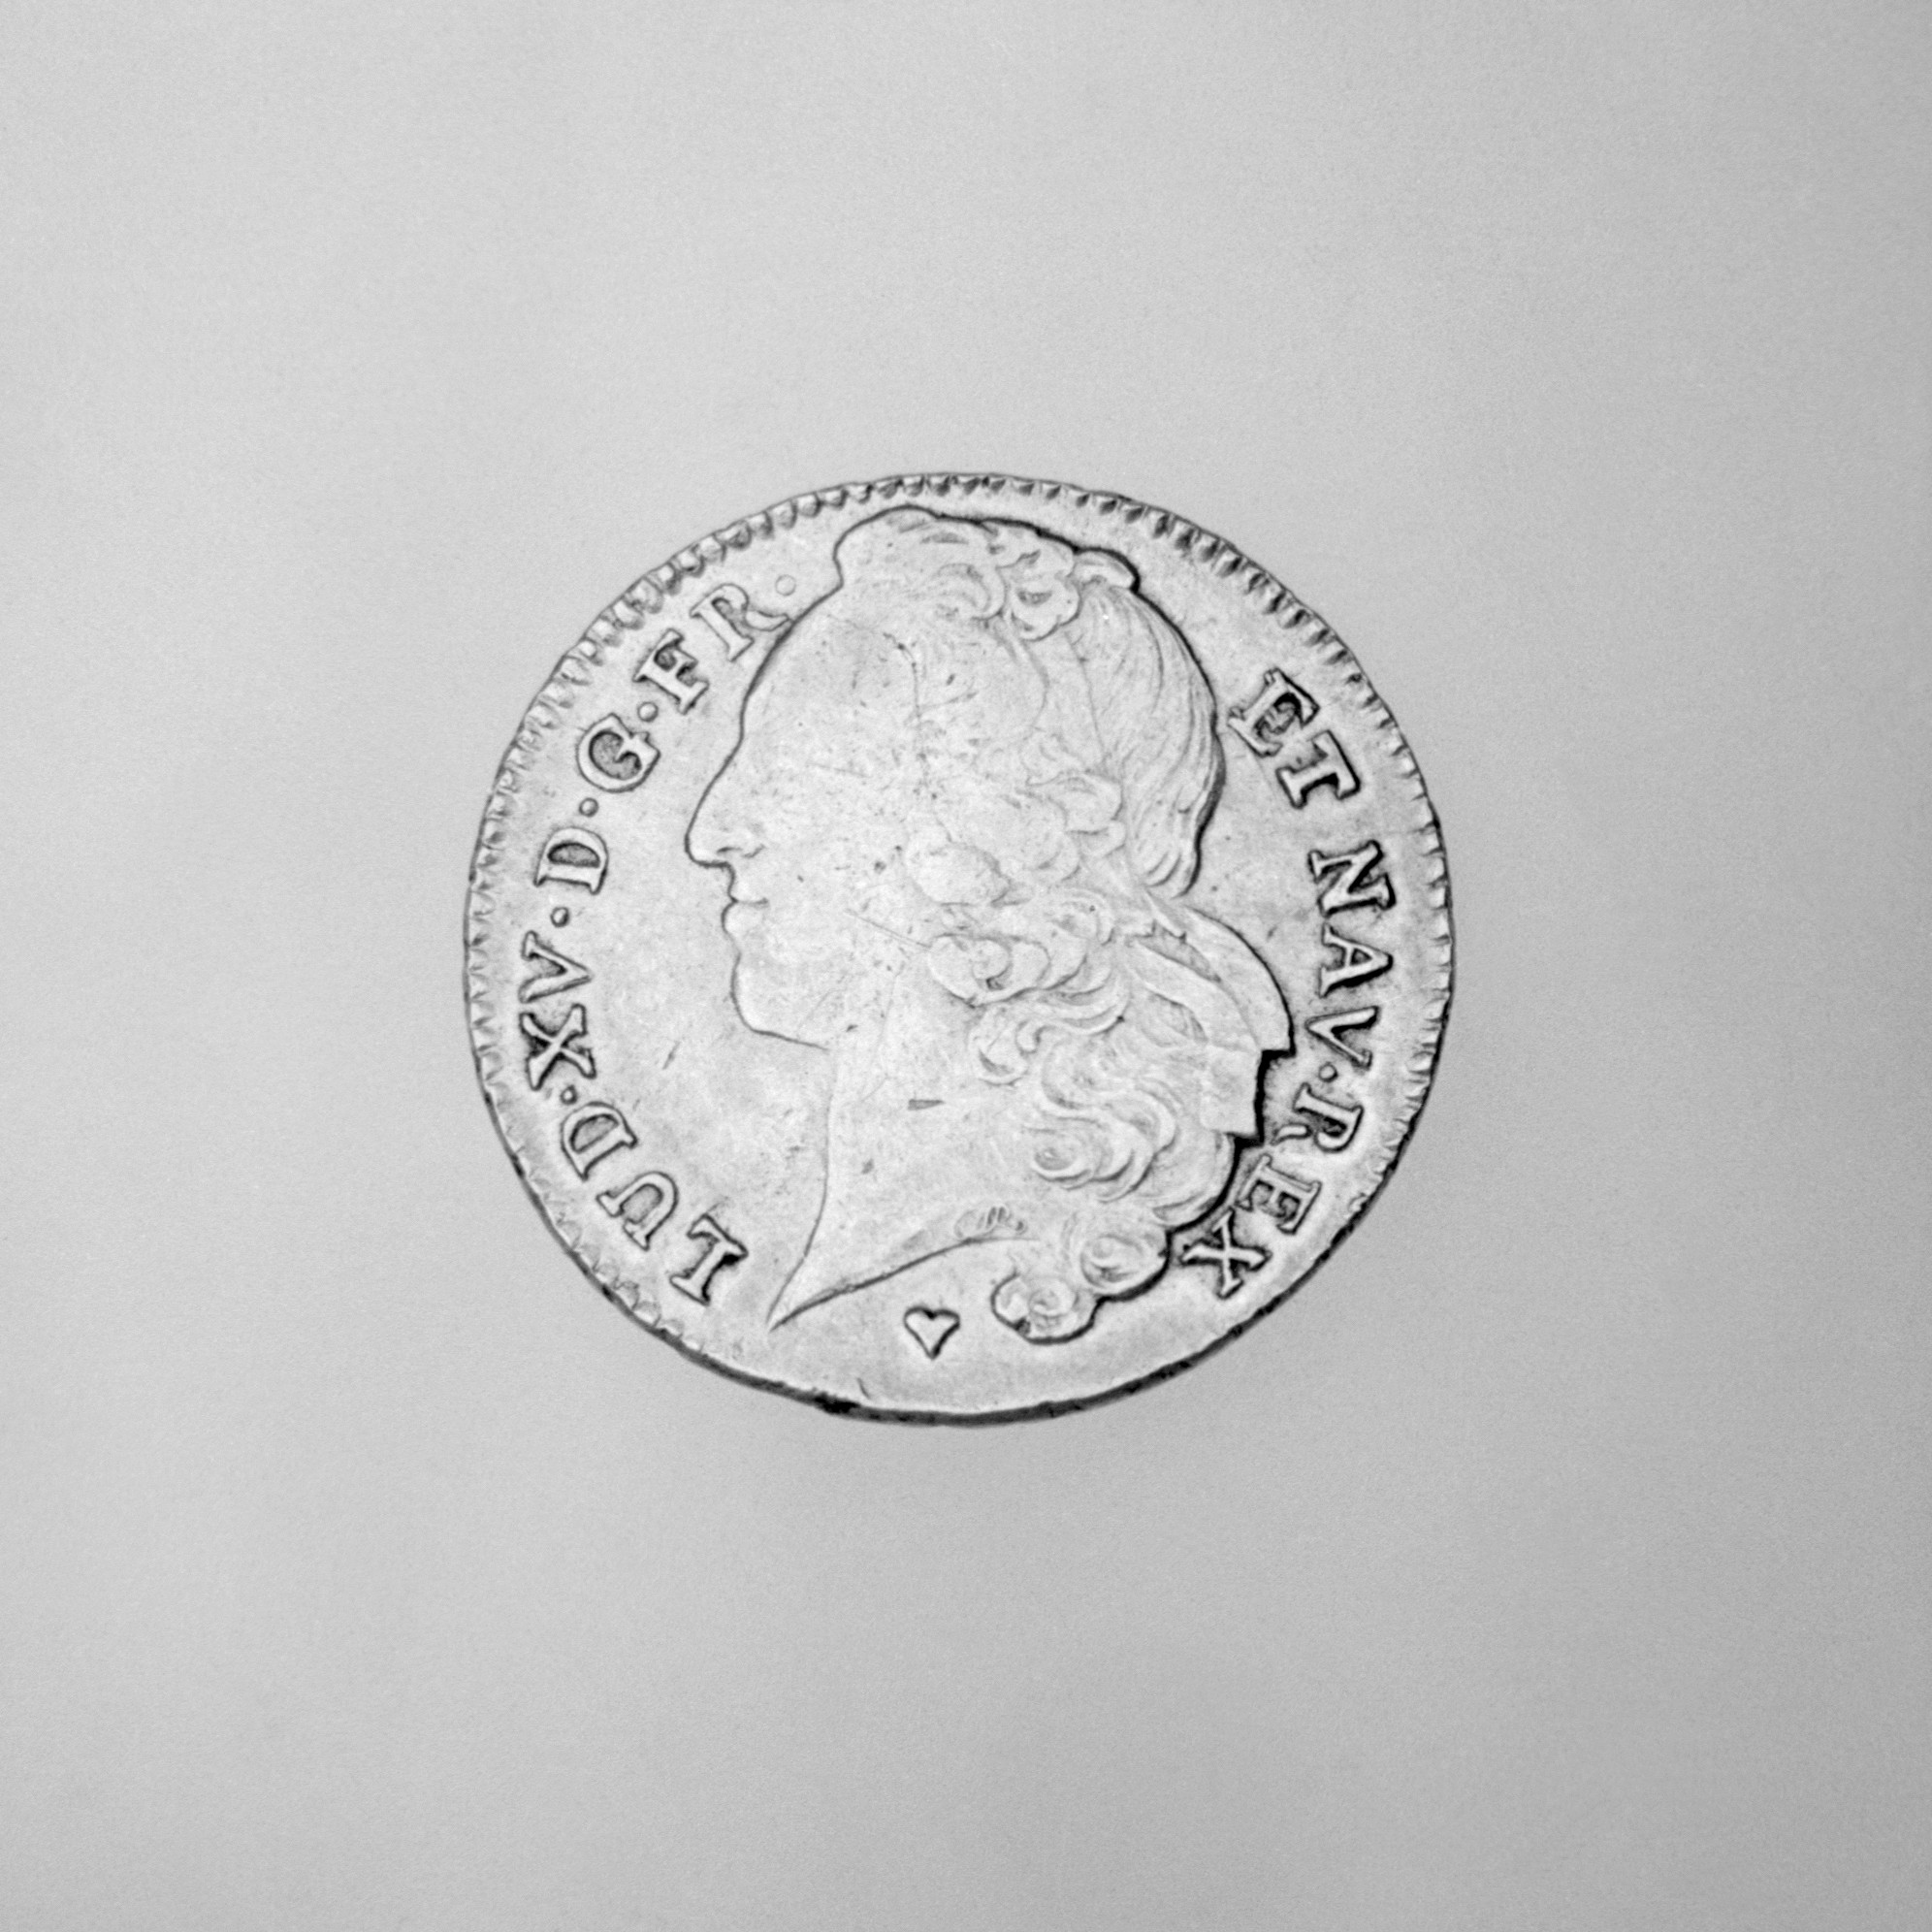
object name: coin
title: Double Louis-d'or of Louis XV of France, 1750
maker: joseph-charles roettiers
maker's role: maker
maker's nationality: french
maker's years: 1691-1779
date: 1759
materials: gold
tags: men,profiles,coins,coat of arms